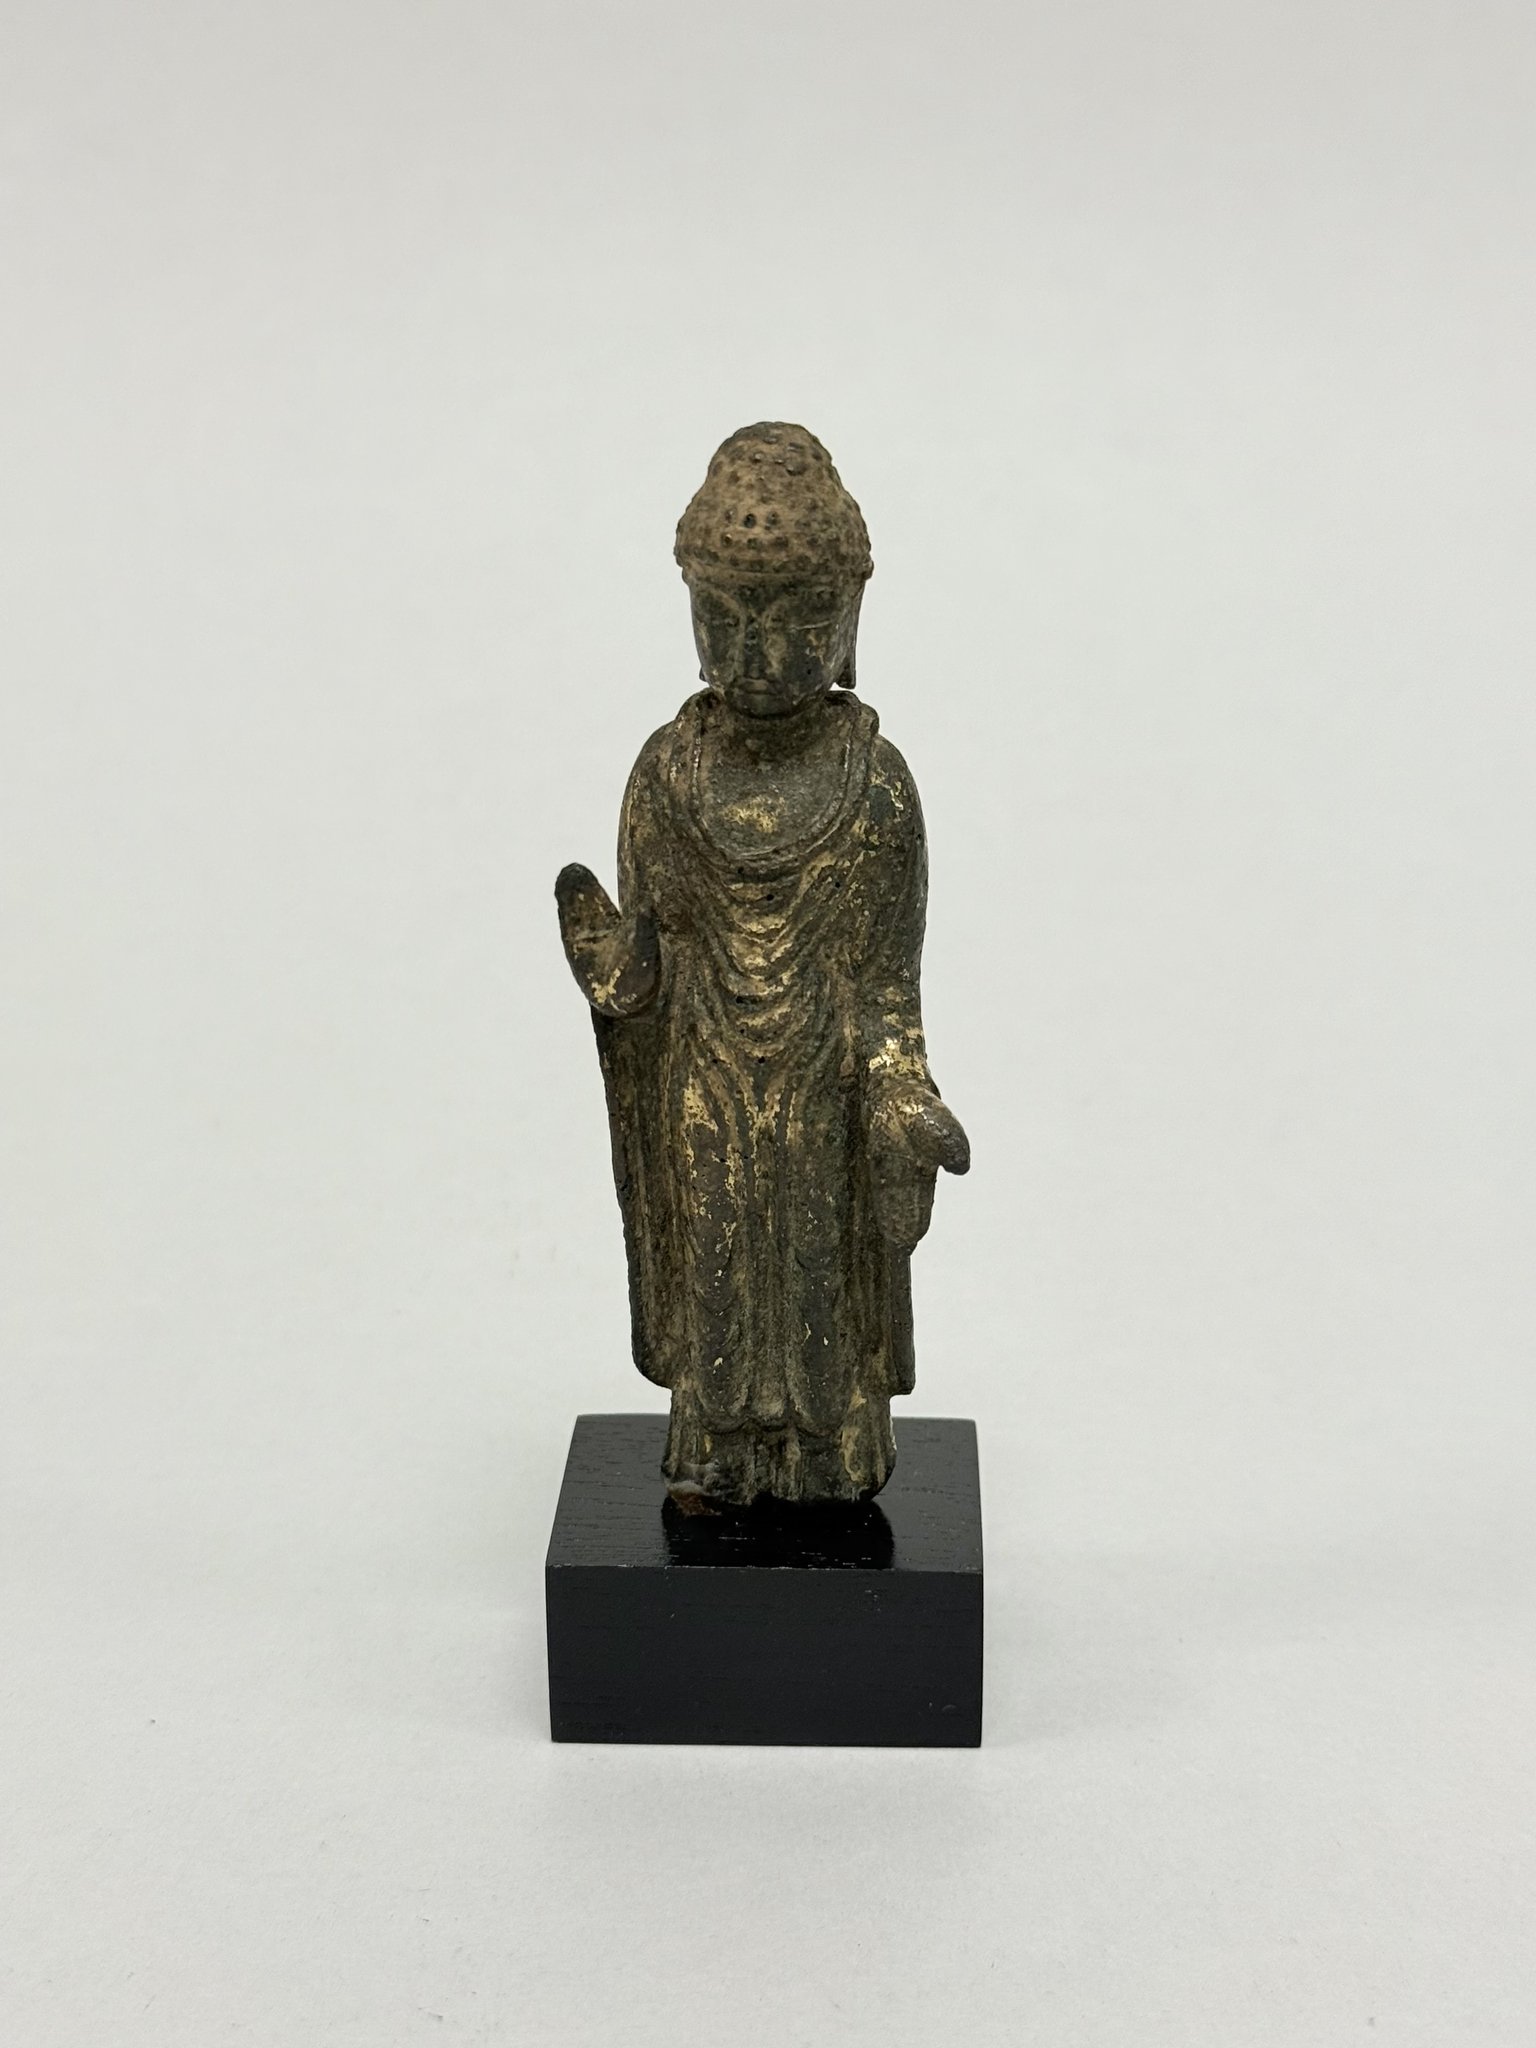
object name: statuette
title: Buddha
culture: korean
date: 601-700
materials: gilt bronze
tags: buddhism,buddha